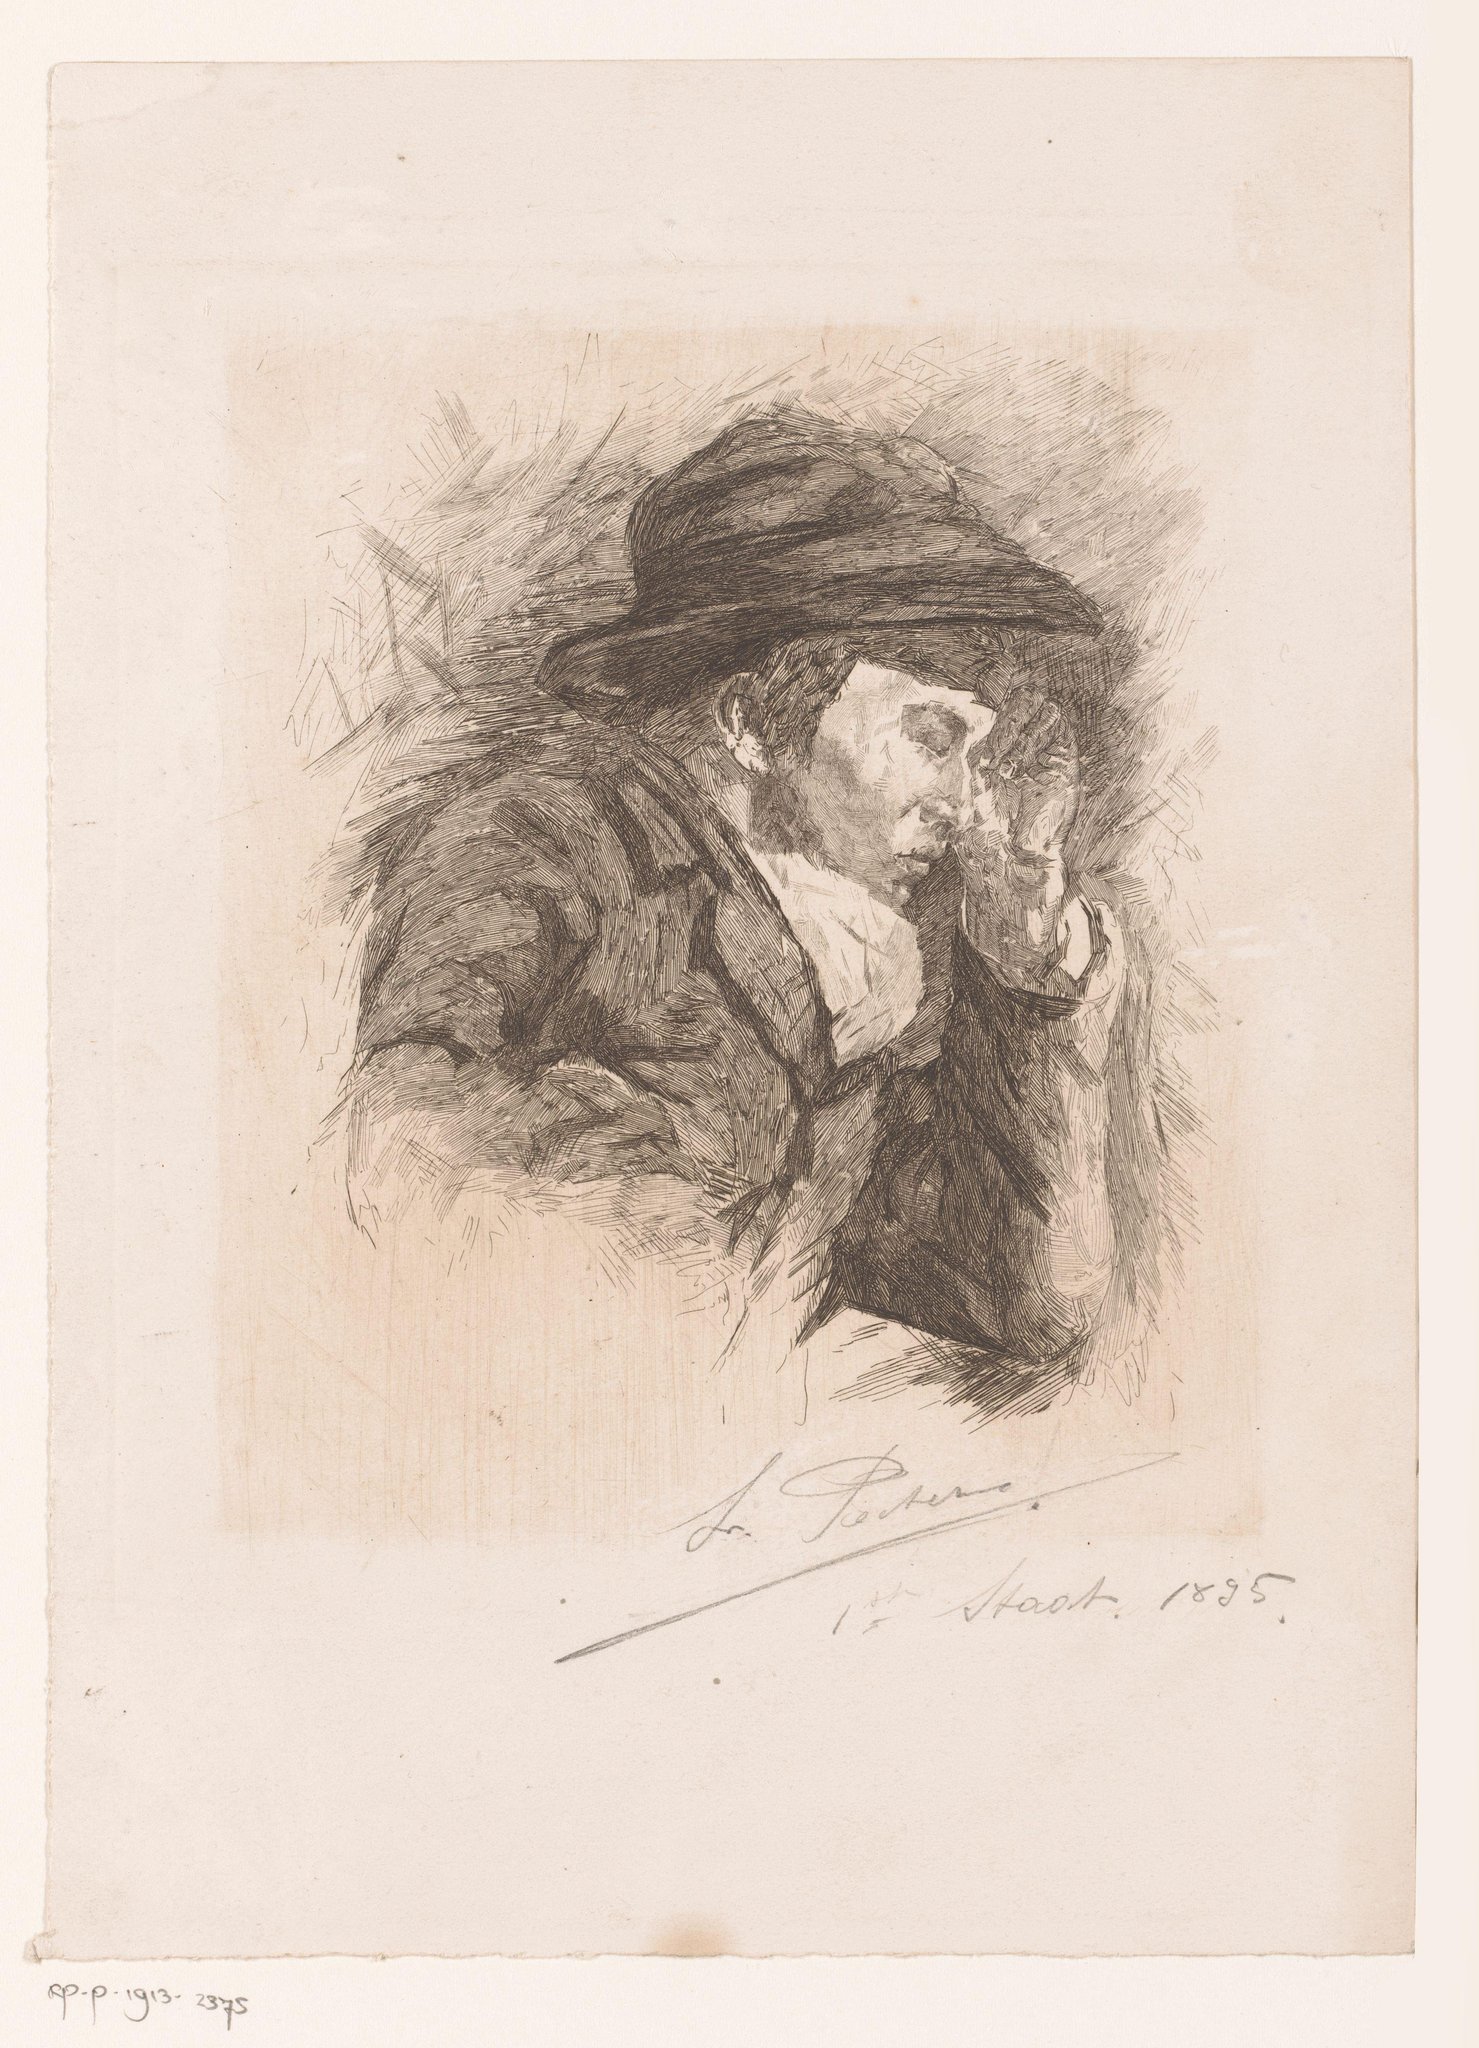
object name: print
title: Man wrijft zich in het oog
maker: louis peeters (i)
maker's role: print maker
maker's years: 1876-1964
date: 1895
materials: paper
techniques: drypoint, etching, intaglio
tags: anonymous historical person portrayed alone, rubbing one's eyes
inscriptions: annotation: ‘1ste staat.’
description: Geboorte- en sterfdatum van de prentmaker zijn onbekend. Daarom is voor de bepaling van de rechten van dit object gebruik gemaakt van de verwervingsdatum Rijksmuseum Amsterdam.